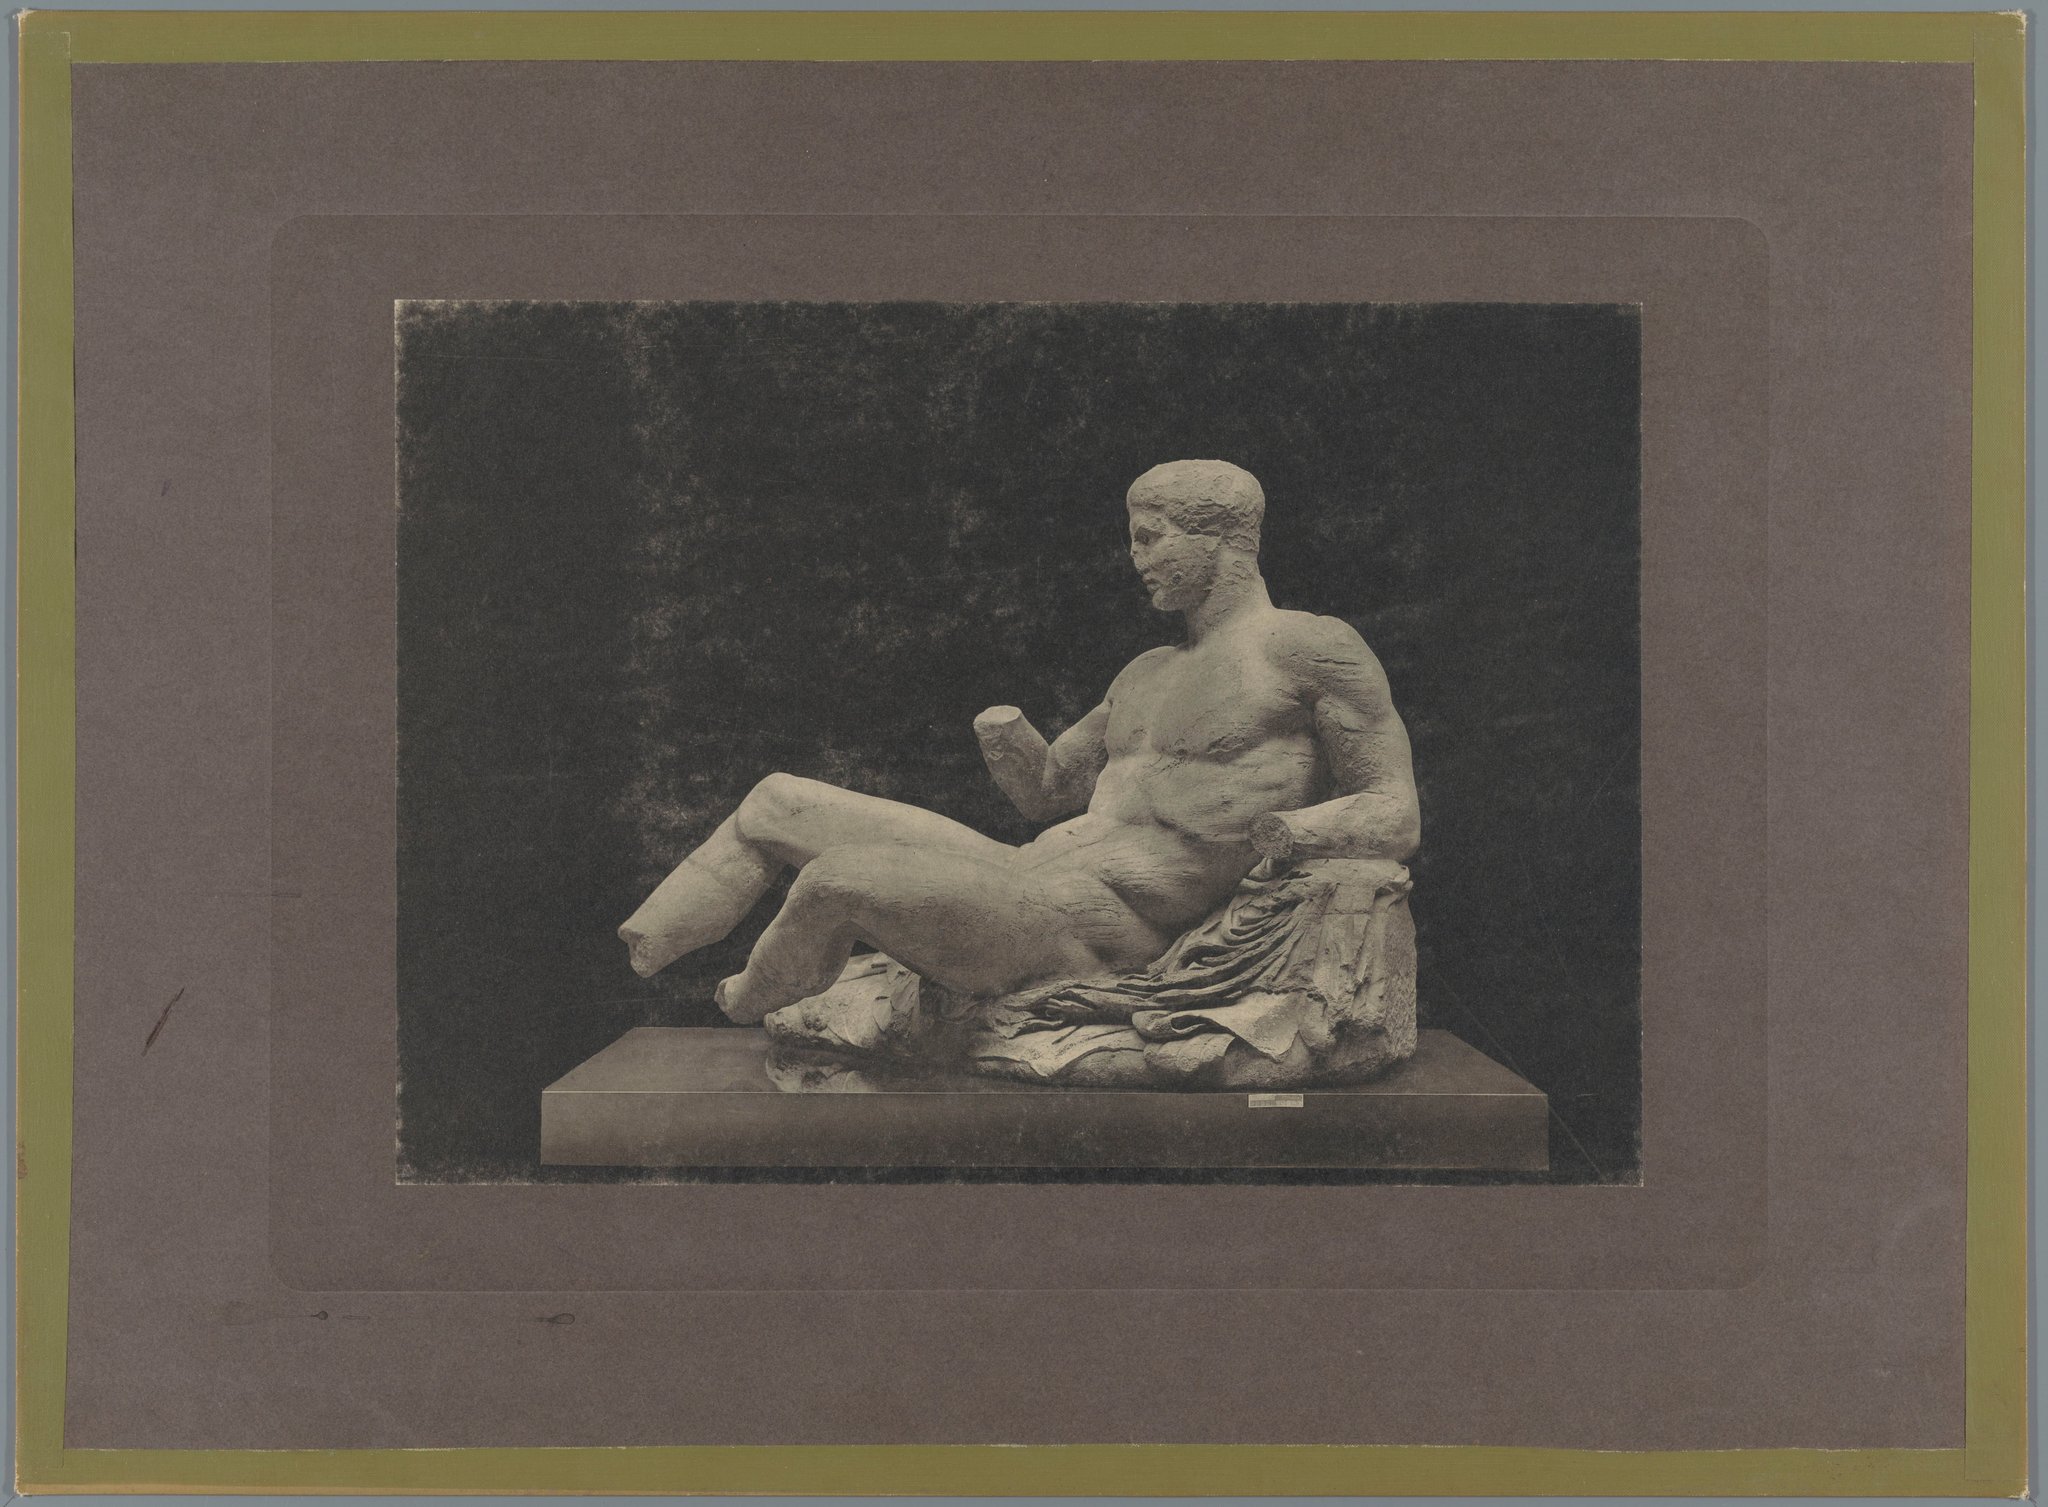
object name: photograph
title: Sculptuur van een liggende man, afkomstig van de oostgevel van het Parthenon te Athene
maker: Anonymous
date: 1896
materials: cardboard, paper, ink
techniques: photograph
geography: munich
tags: monument, statue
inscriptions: inscription:, number: ‘No. 15.’, collector's mark: Lugt 3937